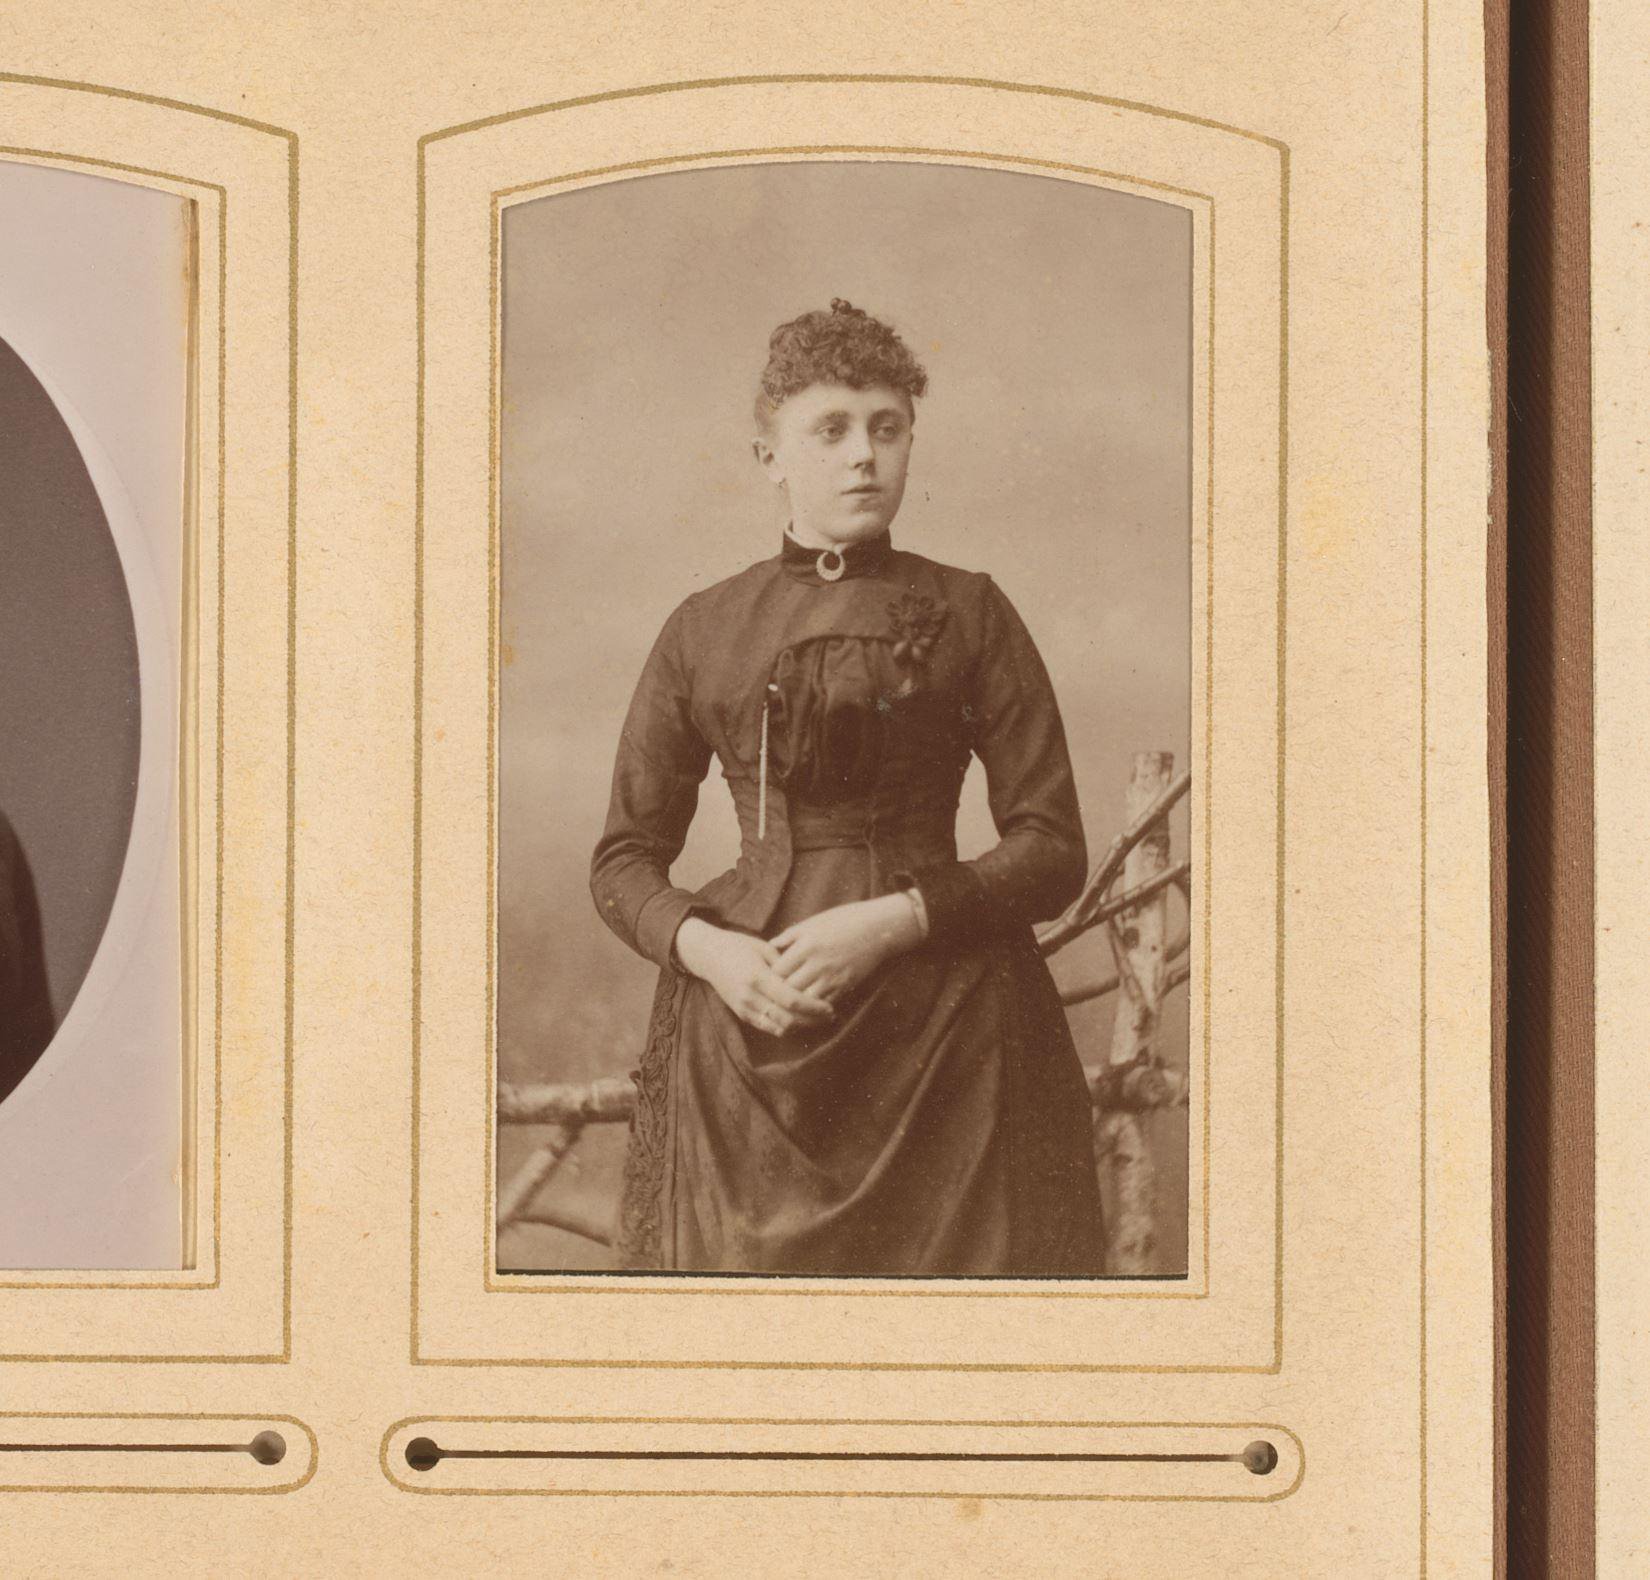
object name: photograph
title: Portret van een jonge vrouw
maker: albert greiner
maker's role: fotograaf, fotostudio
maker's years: 1833-1890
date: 1878-1887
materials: cardboard, photographic support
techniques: albumen print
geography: amsterdam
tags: adolescent, young woman, maiden, historical persons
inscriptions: inscription: ‘(...)/ ALBERT GREINER/ KON. NED. HOF-PHOTOGRAAF/ AMSTERDAM/ NIEUWENDIJK 89./ Specialiteit in Vergrootingen.’